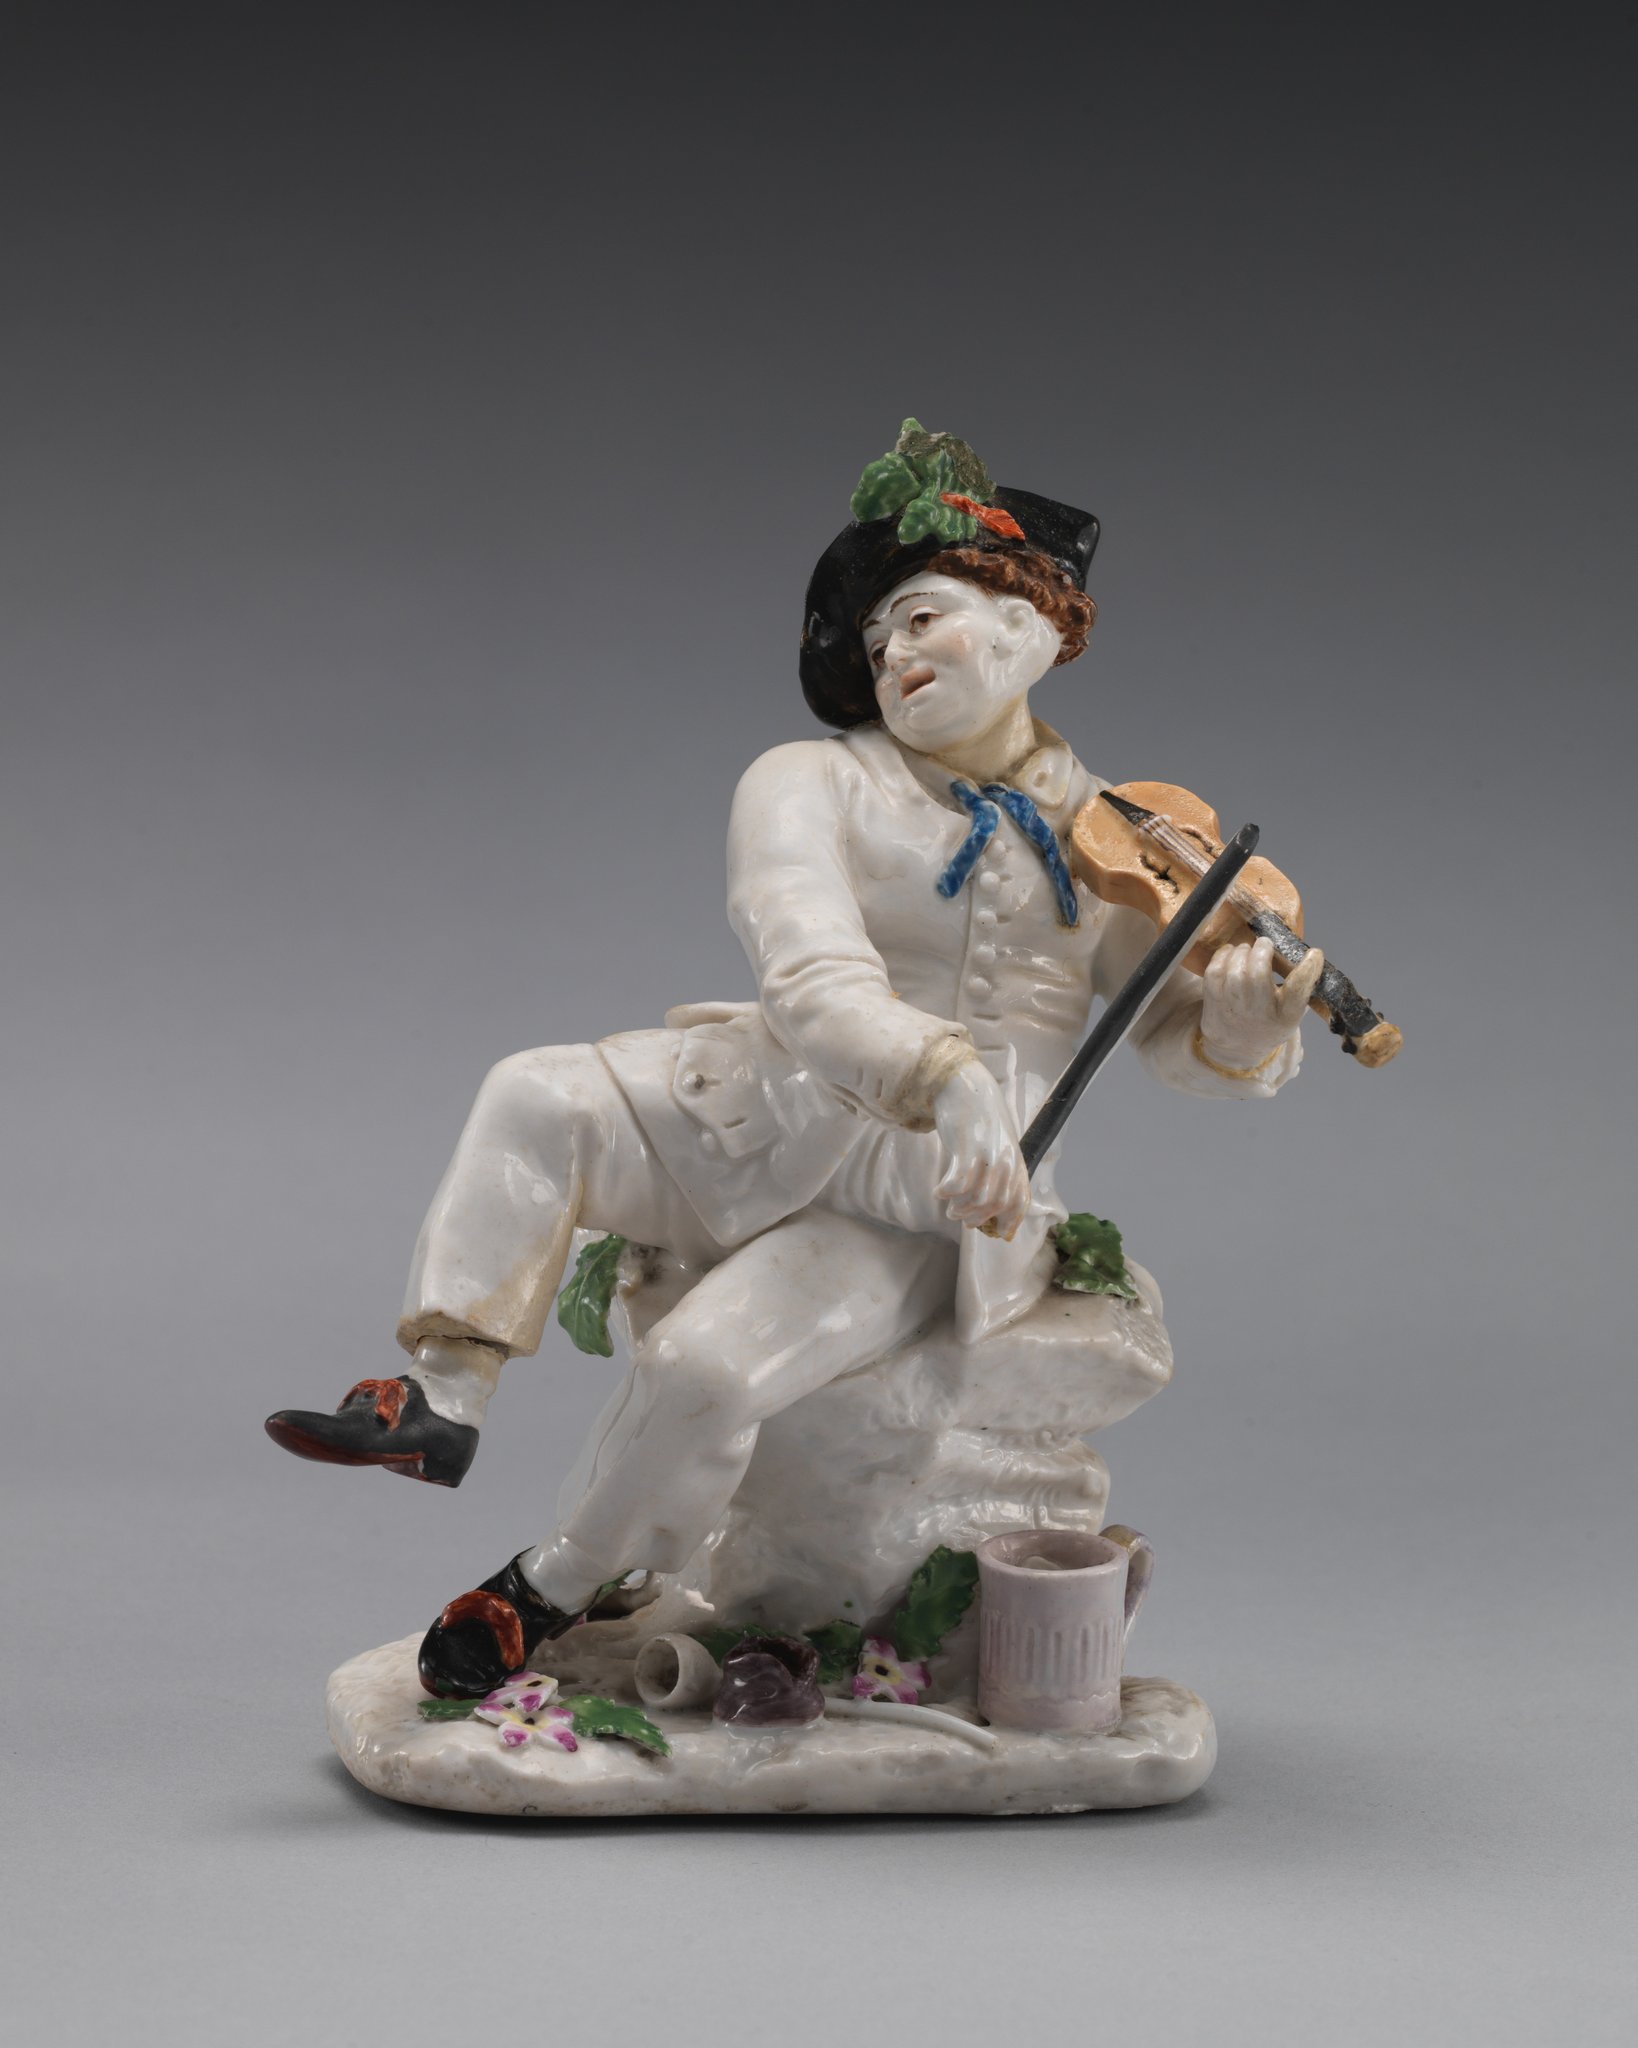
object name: figure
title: Fiddler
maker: chelsea porcelain manufactory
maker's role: factory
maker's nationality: british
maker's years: 1744-1784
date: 1755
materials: soft paste porcelain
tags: men,violins